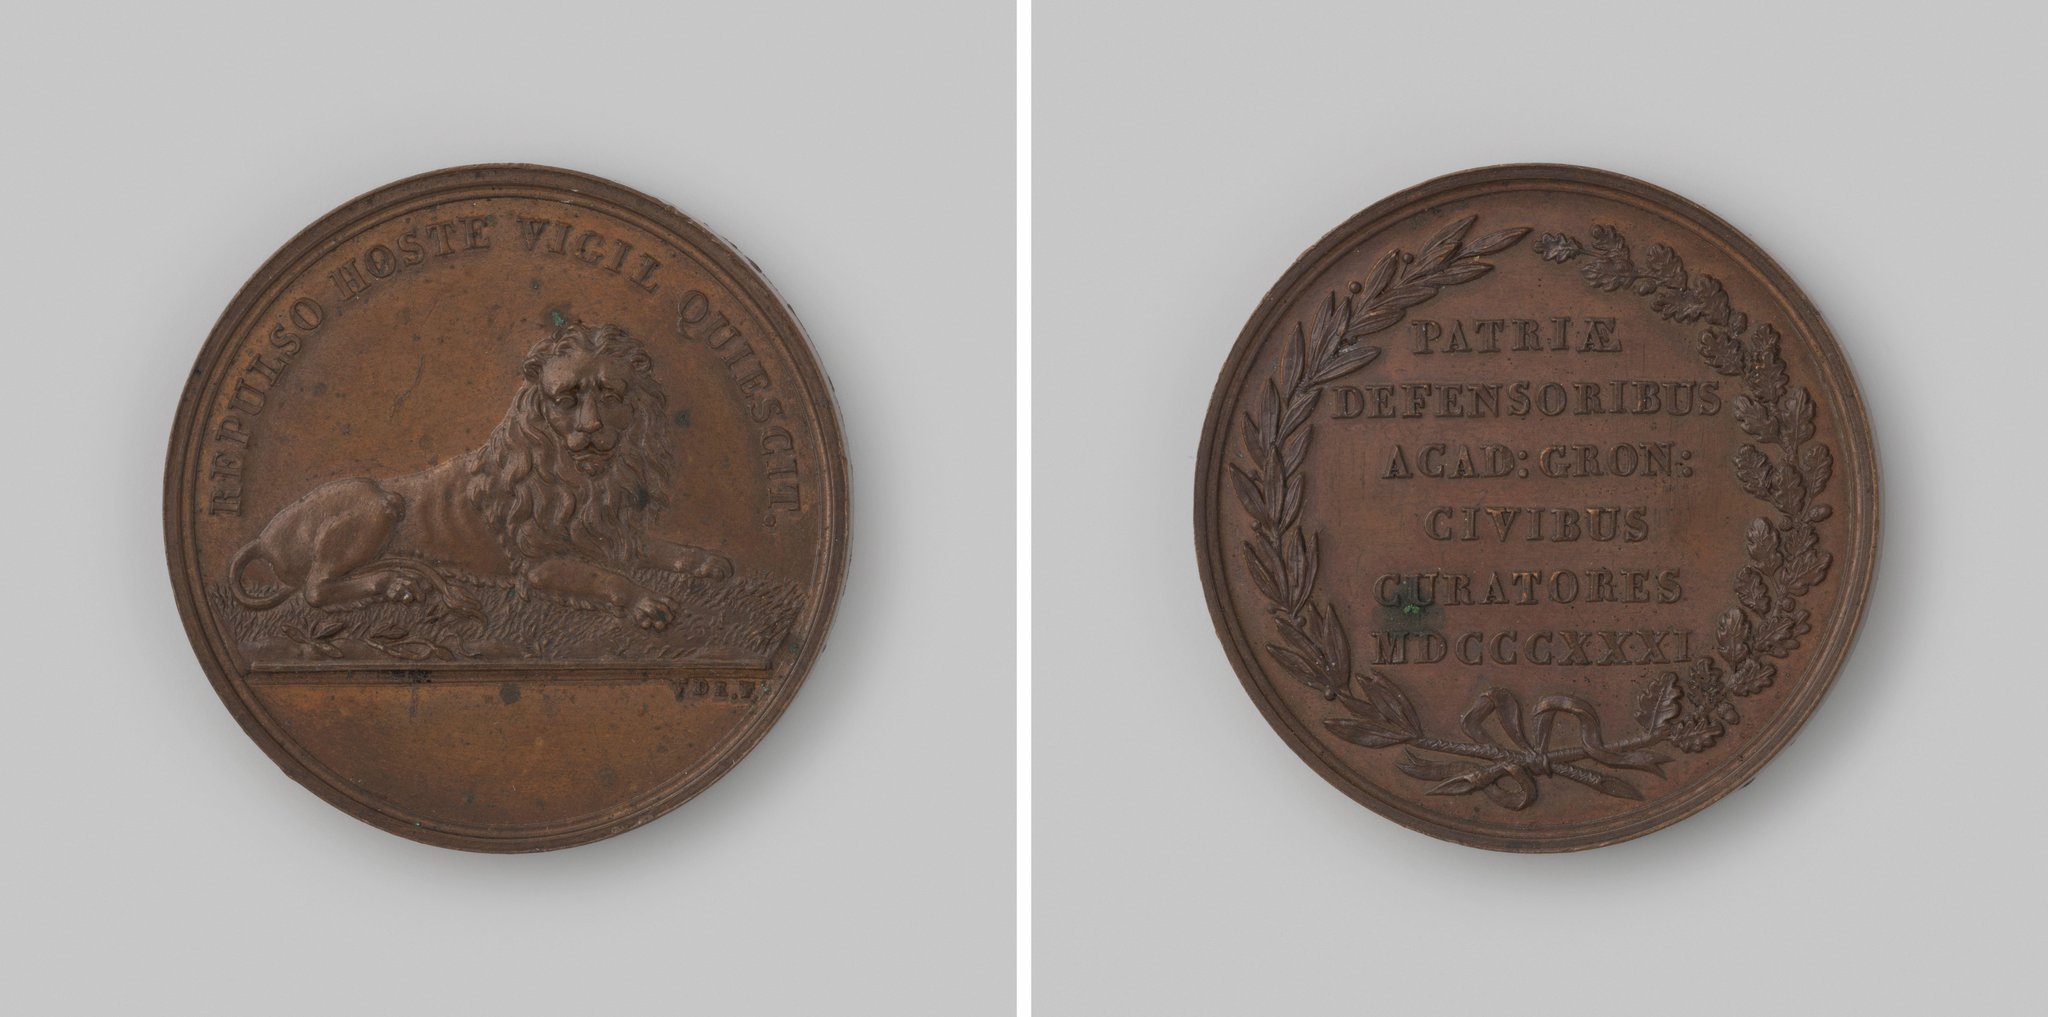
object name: history medal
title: Huldepenning door de curatoren van de Groninger Academie geschonken aan de Groninger en Franeker studenten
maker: david van der kellen (1804-1879)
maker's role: die cutter, draughtsman, print maker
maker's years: 1804-1879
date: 1831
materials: bronze